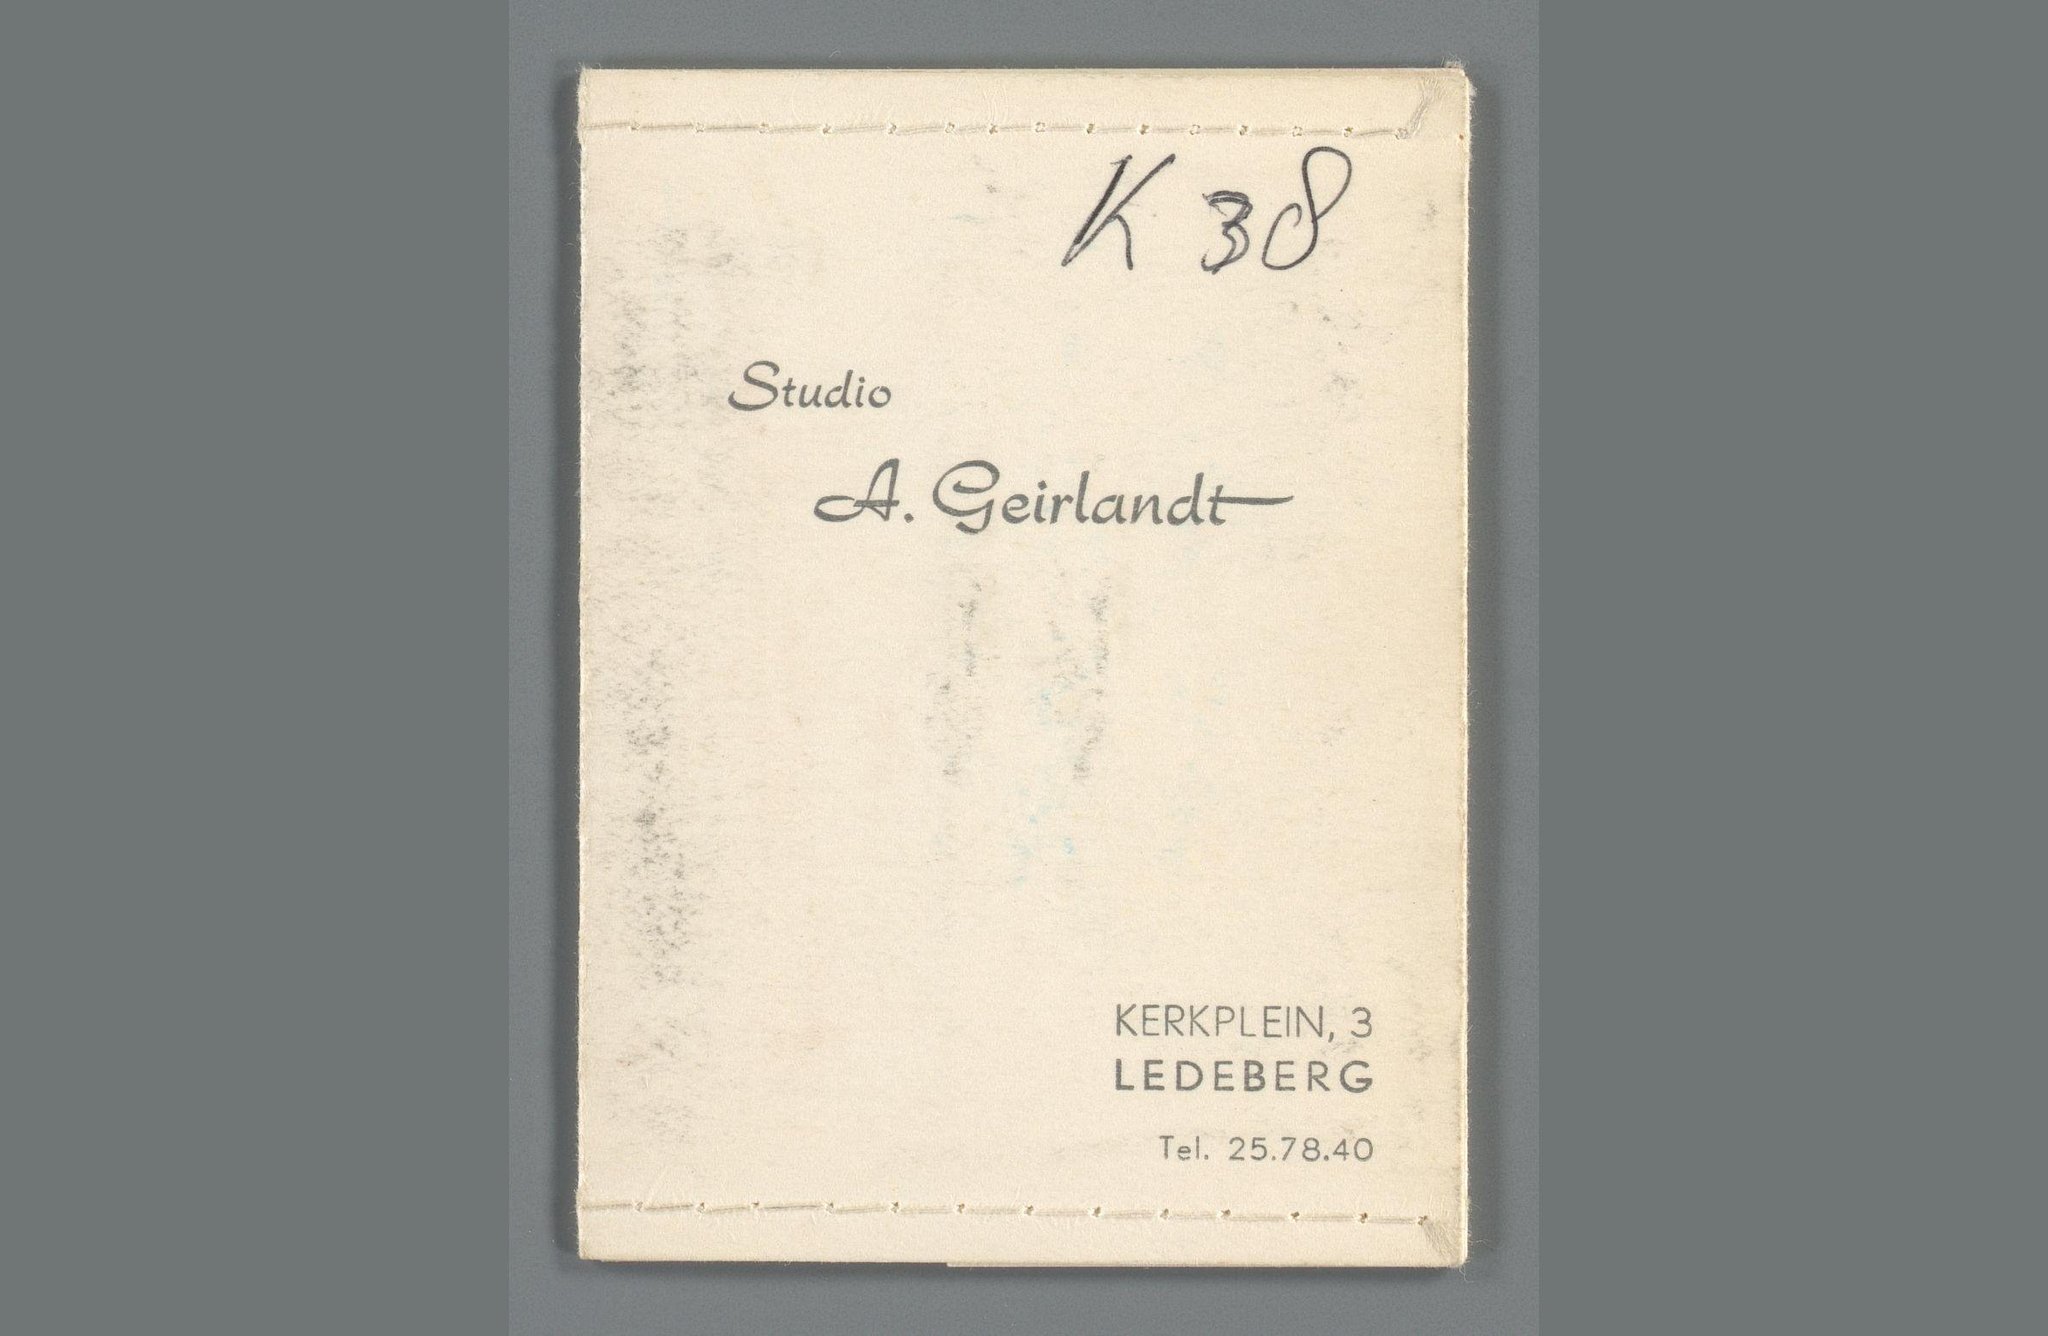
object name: photomap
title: Map voor een pasfoto van A. Geirlandt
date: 1950-1970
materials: cardboard, ink, textile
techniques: letterpress printing, pen, stitching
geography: ledeberg